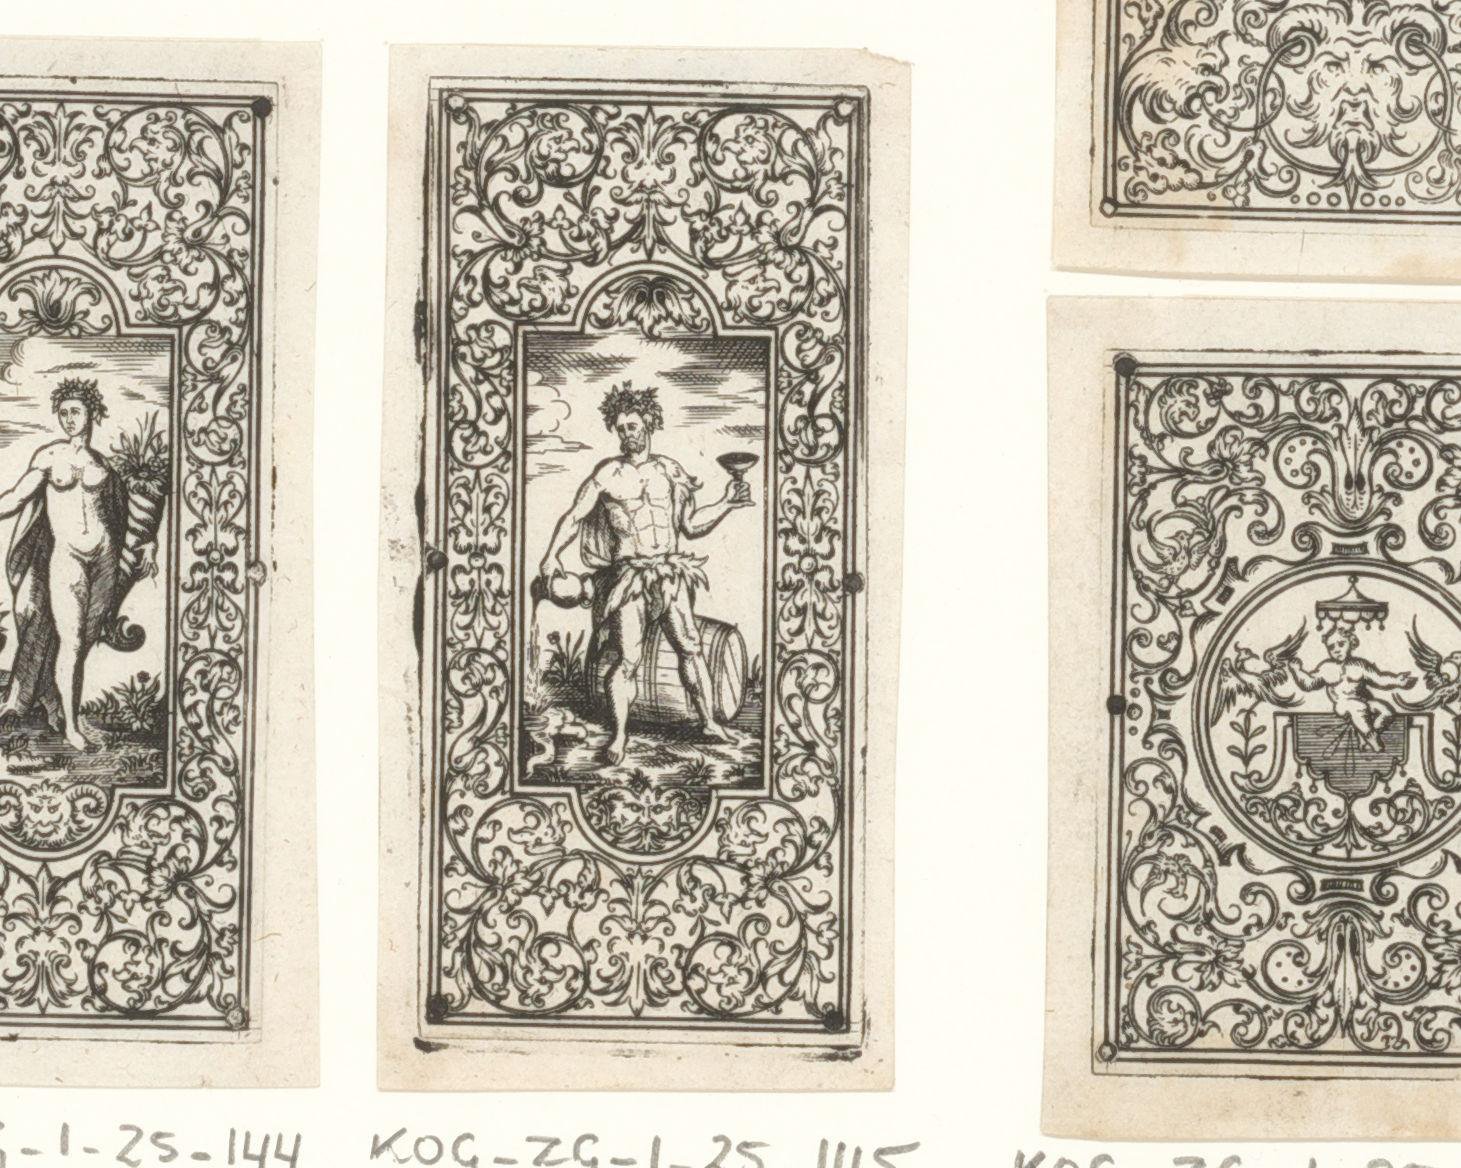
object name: print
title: Bacchus des overvloeds in ornamentele omlijsting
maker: Anonymous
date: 1600-1699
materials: paper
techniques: engraving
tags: ceres, patroness of agriculture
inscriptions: collector's mark: Lugt 963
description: Onderwerpsrubrieken binnen de Atlas Zeden en Gewoonten: Zeden en Gewoonten in Engeren Zin, De Woning, Huisraad, Zilverwerk.